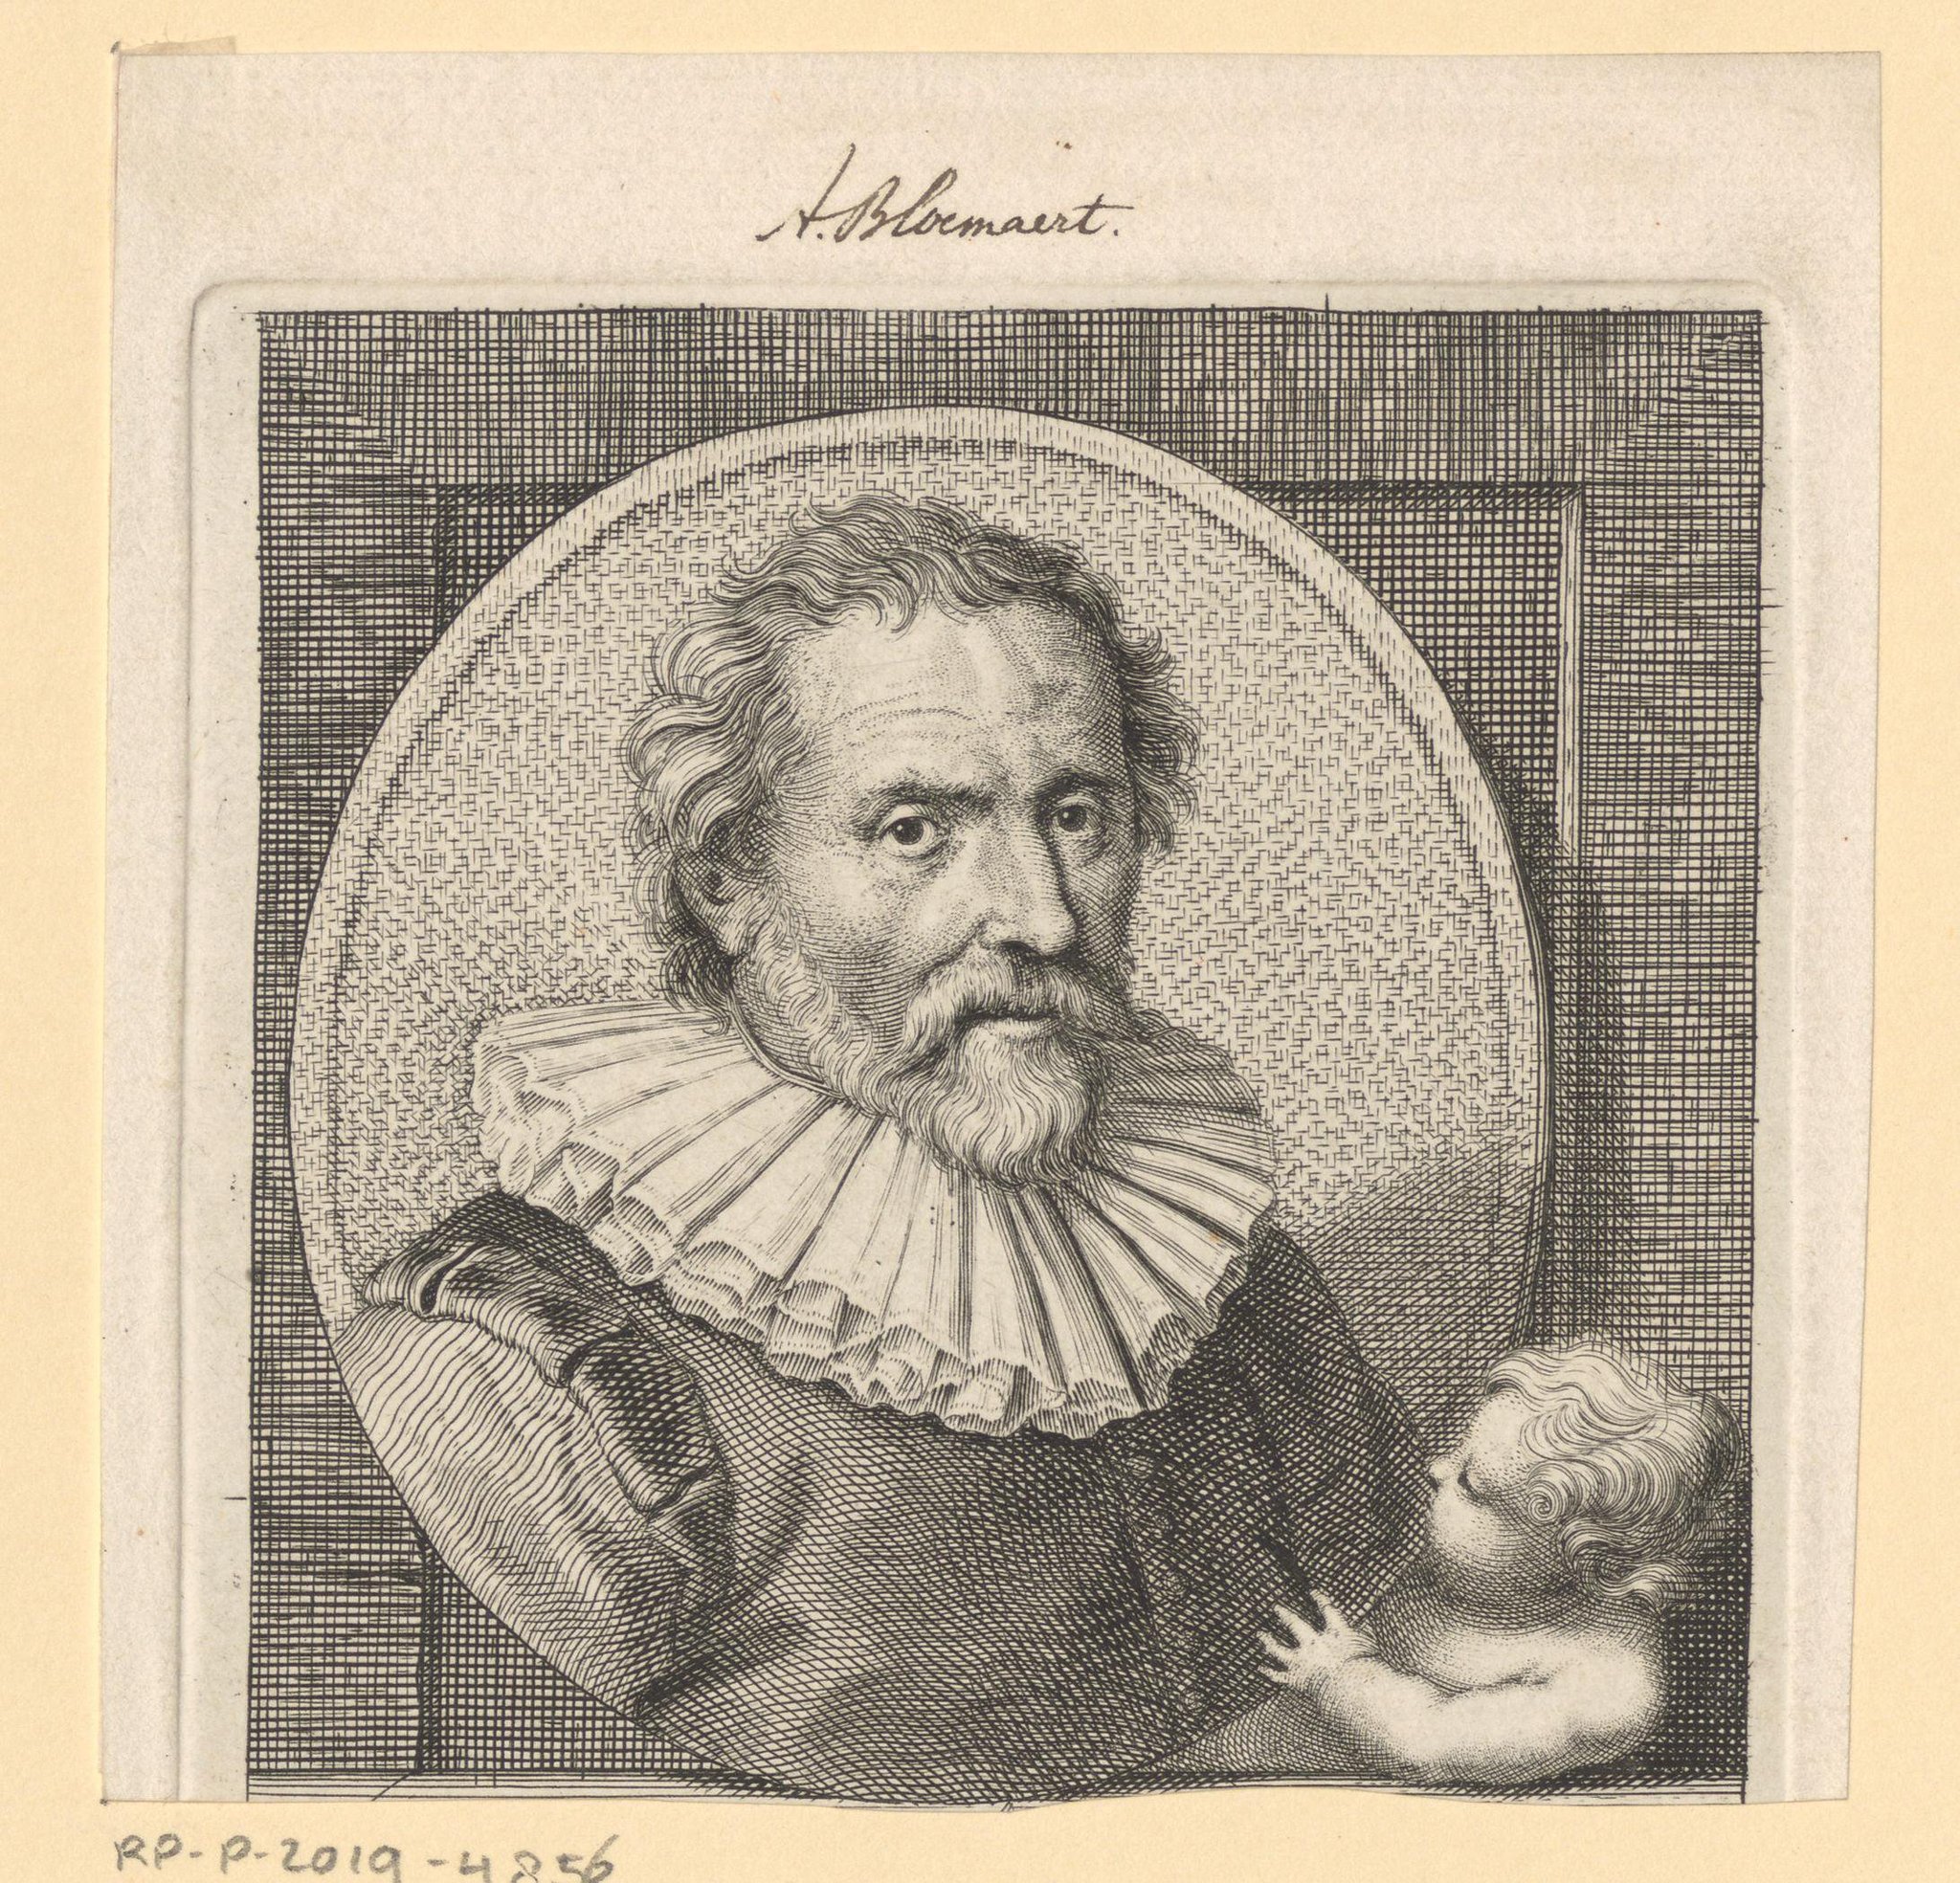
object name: book illustration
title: Portret van Abraham Bloemaert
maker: jacob houbraken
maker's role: draughtsman, print maker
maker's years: 1698-1780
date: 1718-1721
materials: paper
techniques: engraving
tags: utrecht, painter, abraham bloemaert, historical persons, portrait, self-portrait of painter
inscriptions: inscription: ‘A. Bloemaert.’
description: Prent uit: Houbraken, Arnold. De groote schouburgh der Nederlantsche konstschilders en schilderessen (...). Den Haag: s.n., 1718-1721, dl. 1.